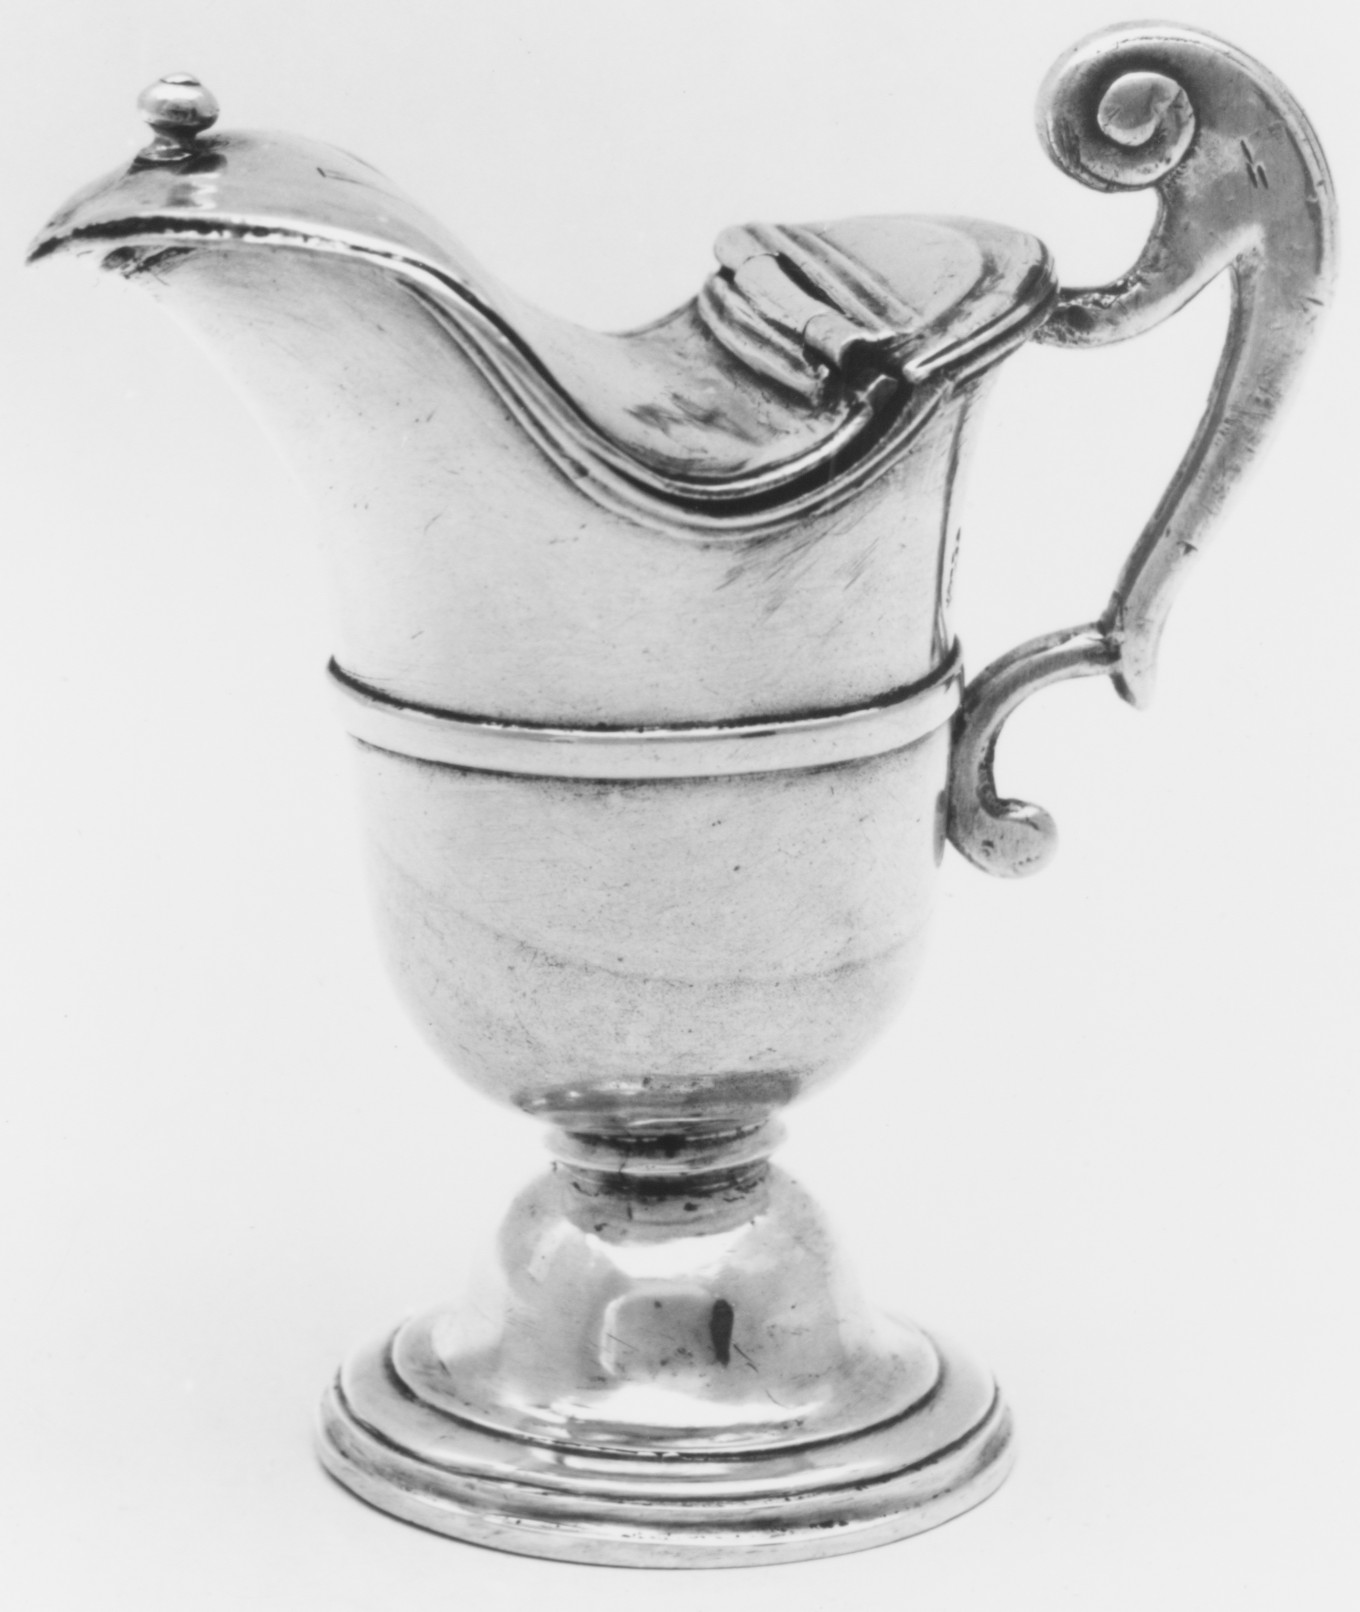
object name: altar cruet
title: Altar cruet (one of a pair)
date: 1701-1750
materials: silver